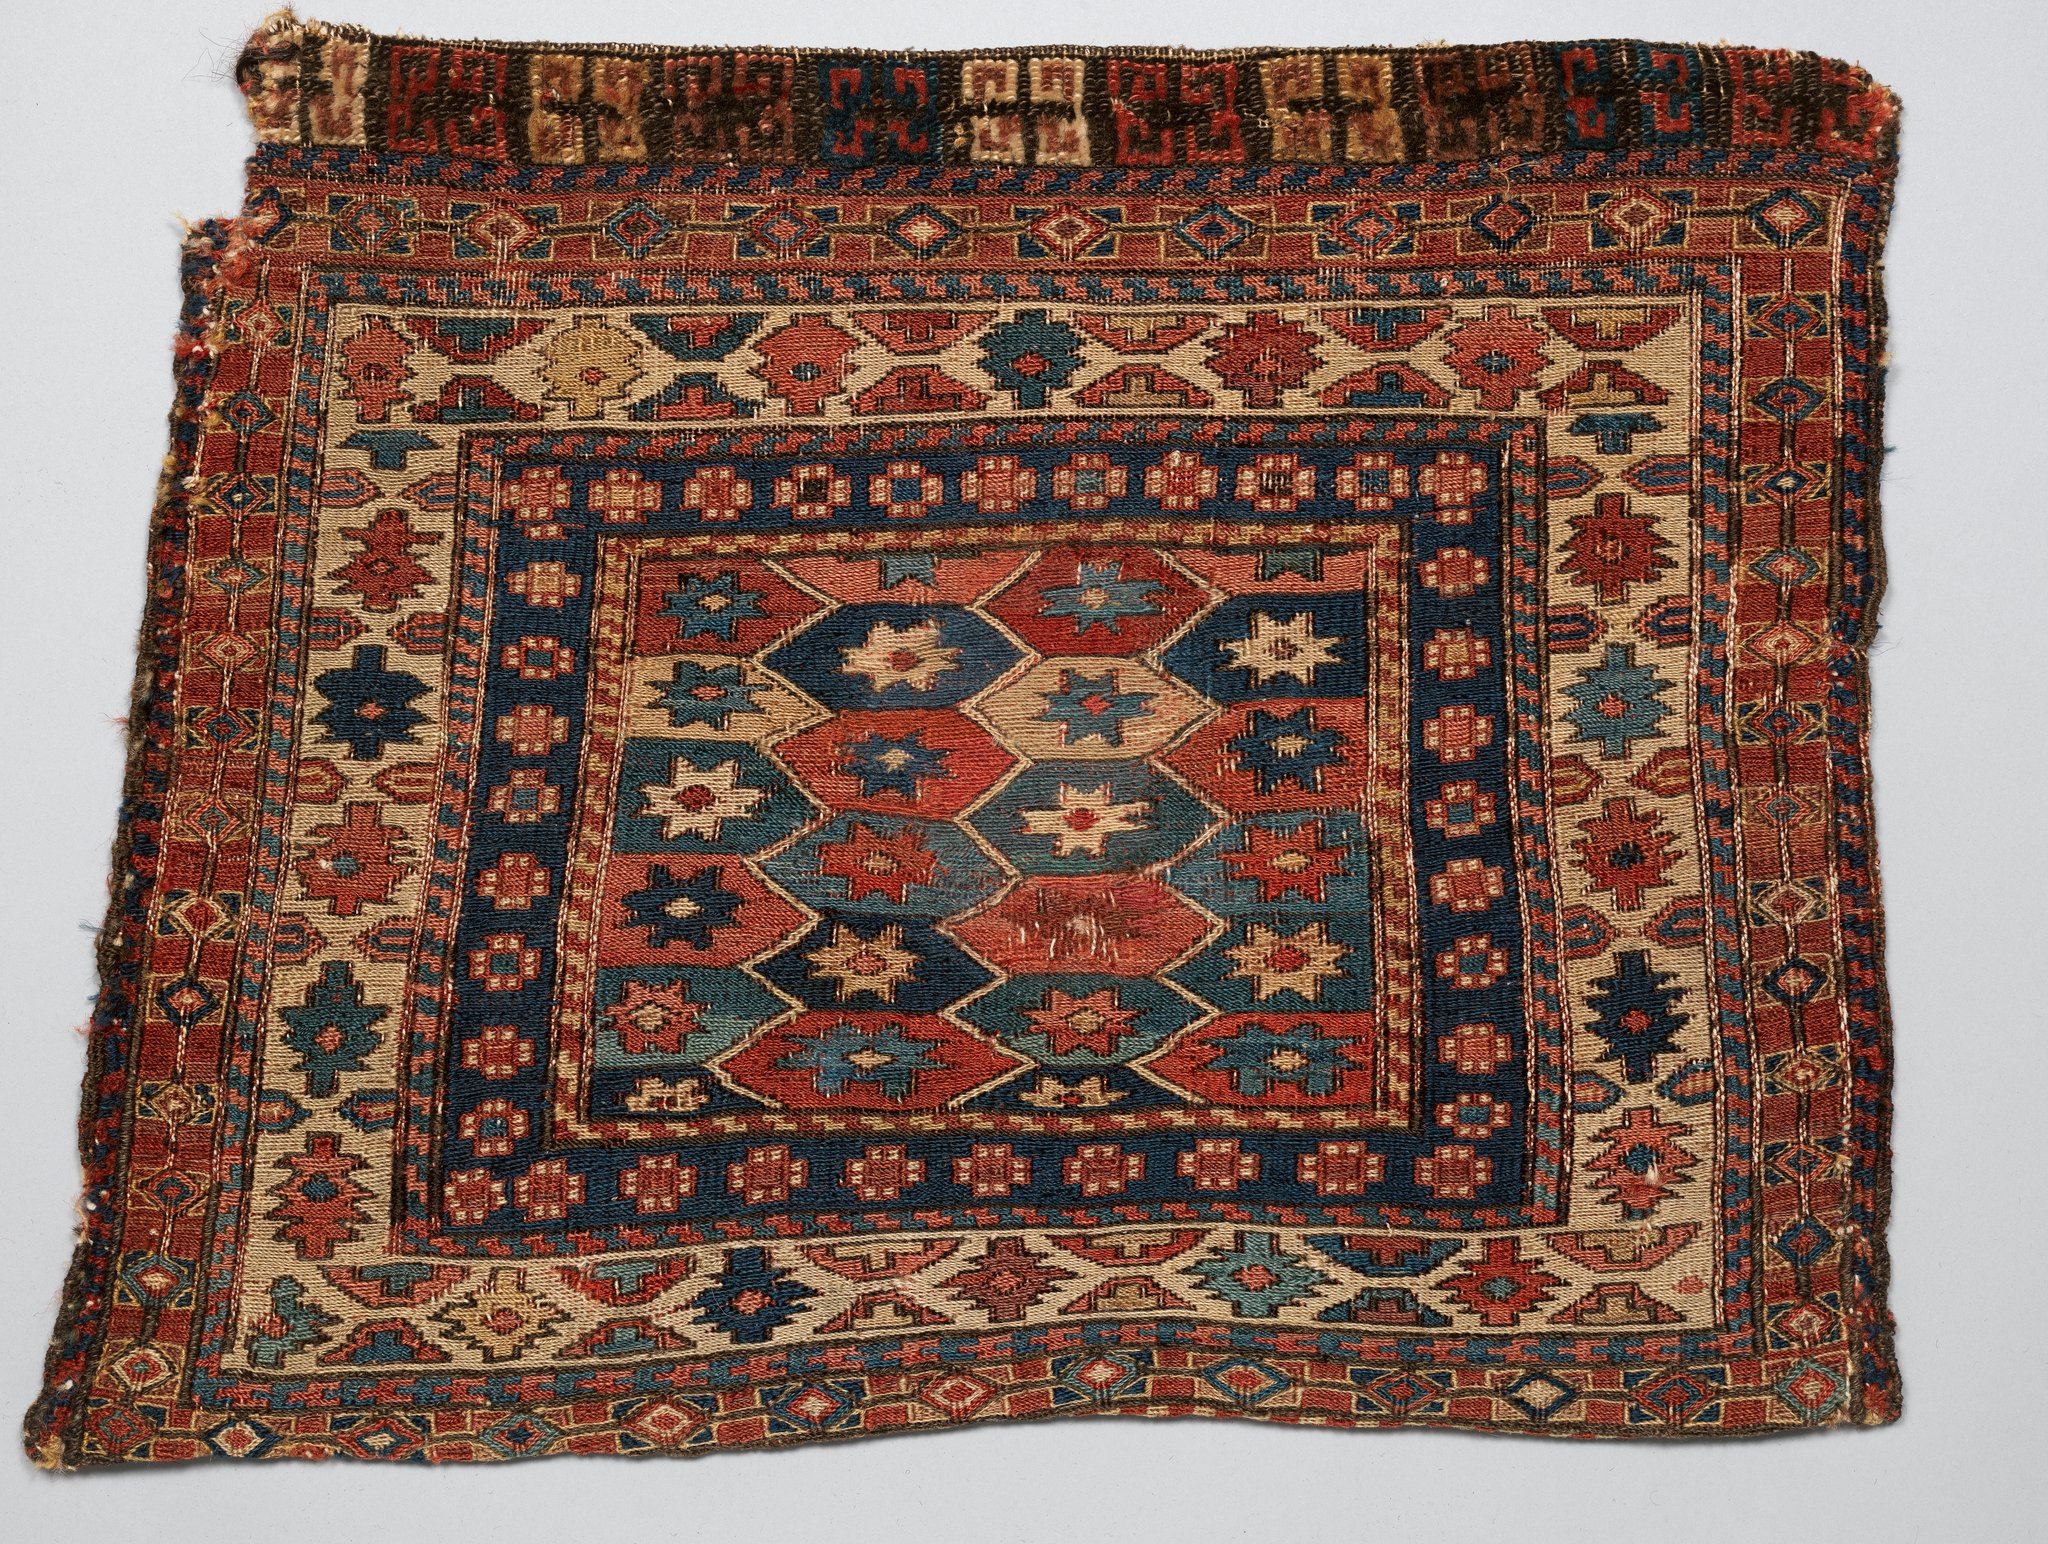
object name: saddle bag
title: Face from Half of Double Saddle Bag (Khorjin)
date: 1800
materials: wool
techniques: brocade, pile, weave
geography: northwestern iran